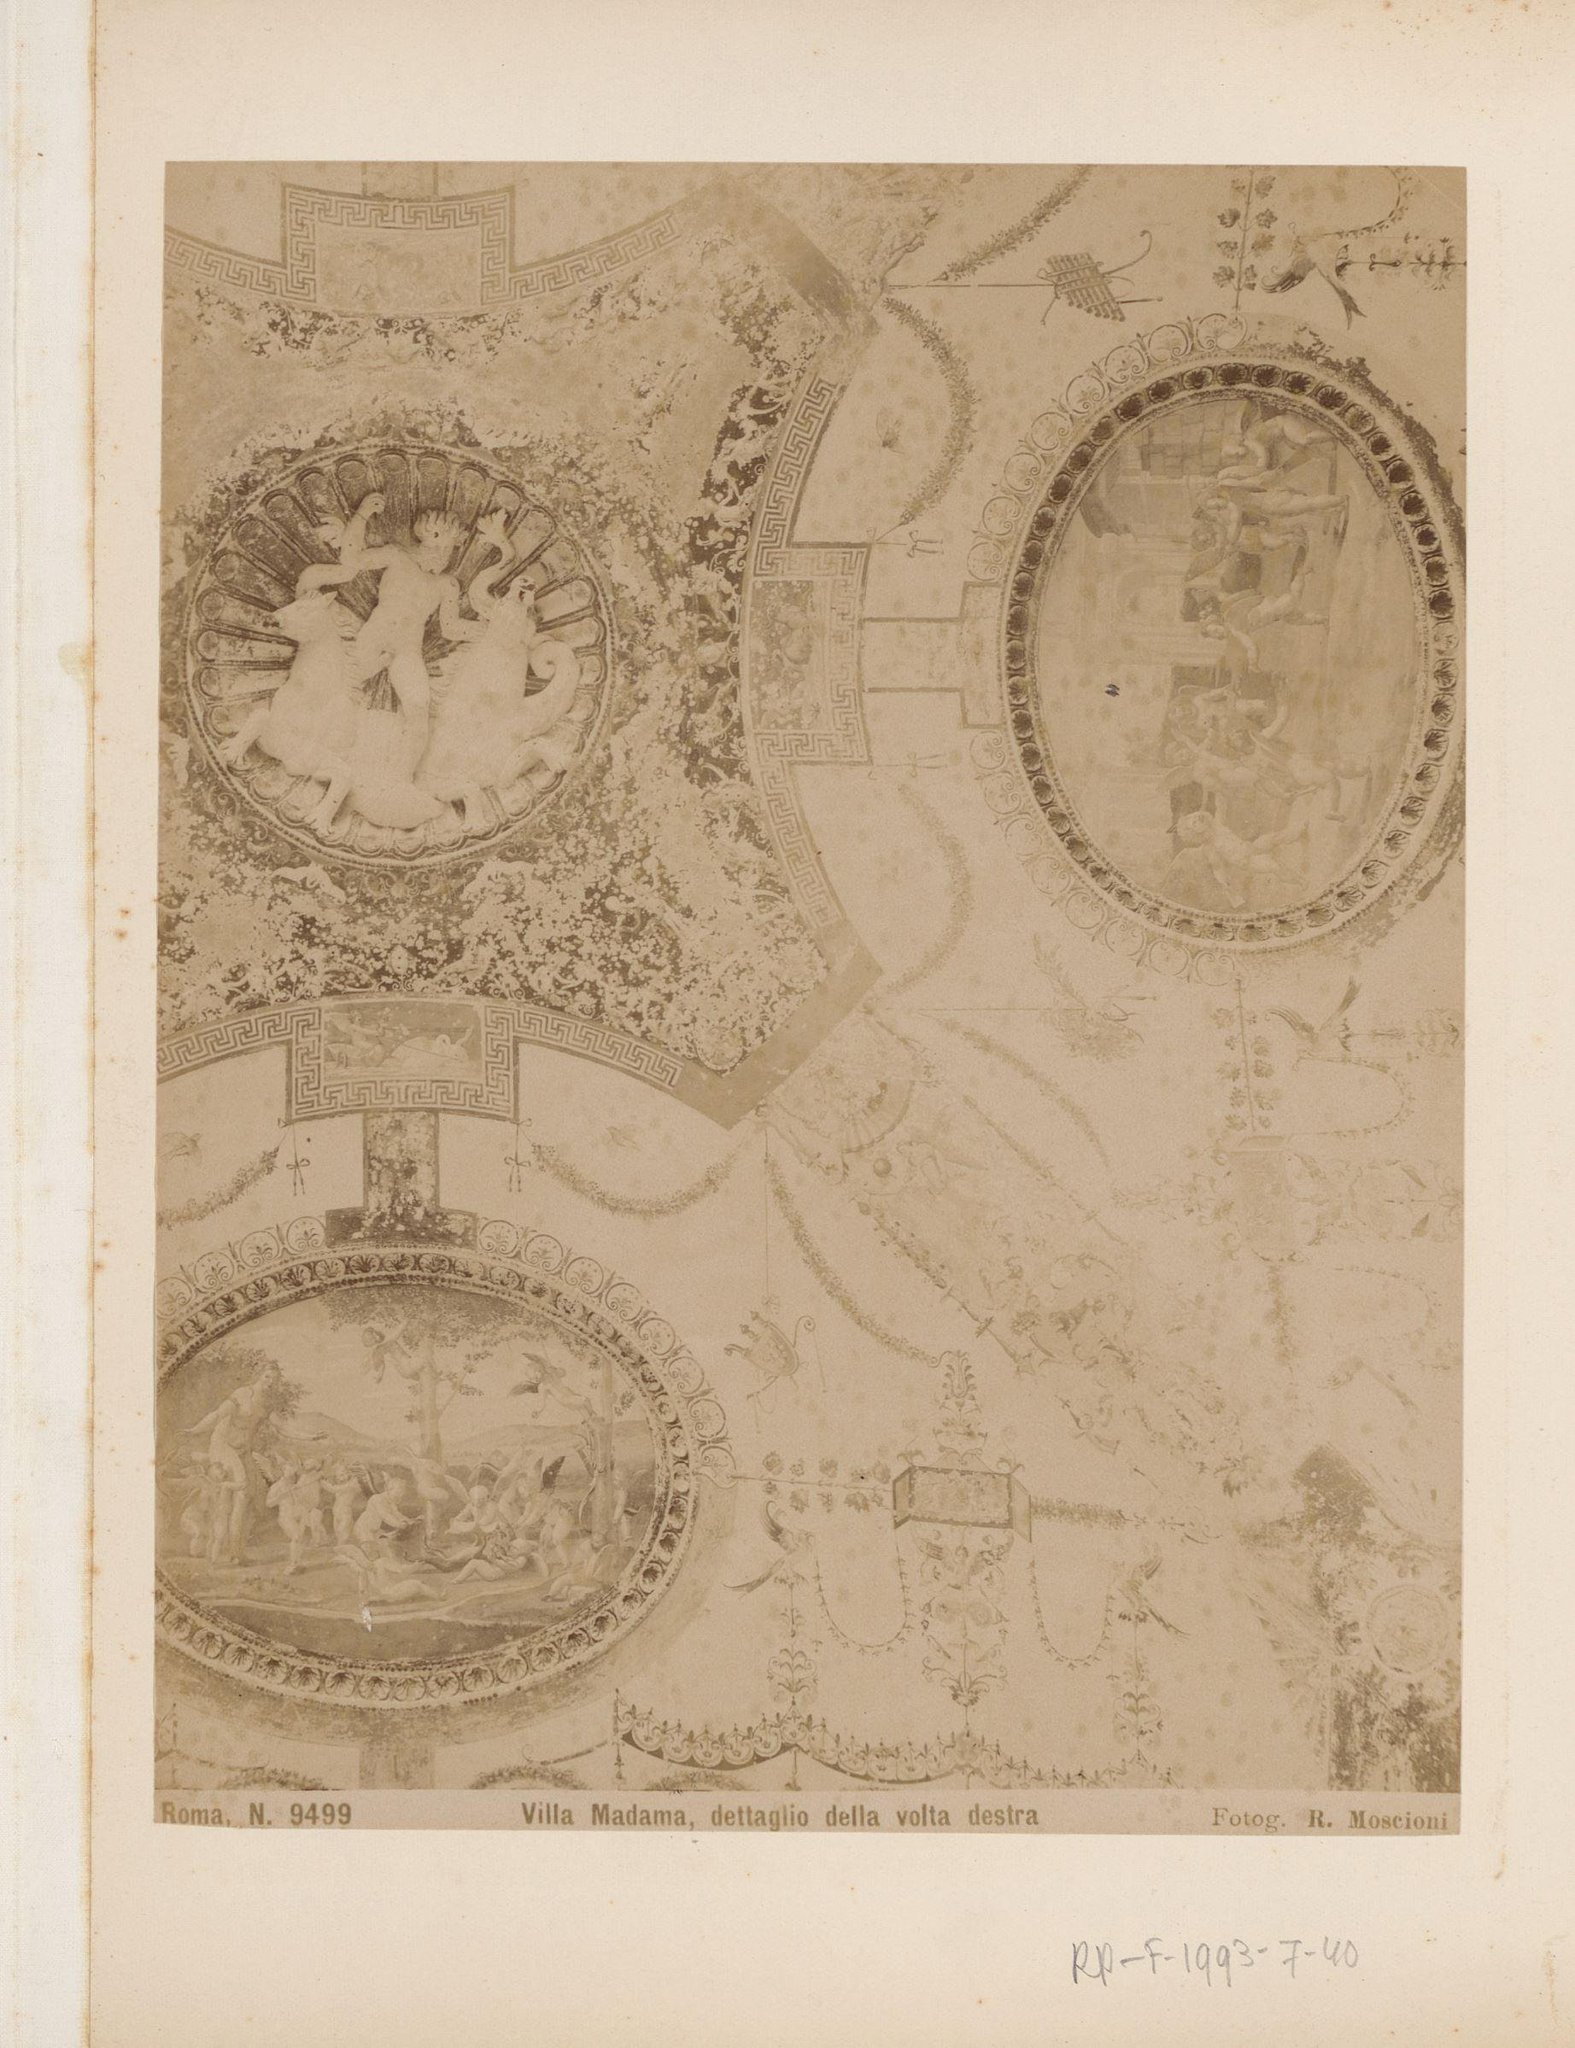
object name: photograph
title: Roma, N. 9499 Villa Madama, dettaglio della volta destra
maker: romualdo moscioni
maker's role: fotograaf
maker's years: 1849-1925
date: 1868-1900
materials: paper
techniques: albumen print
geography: villa madama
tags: villa - aa - civic architecture: inside, vault ~ architecture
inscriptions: inscription: ‘Roma, N. 9499 Villa Madama, dettaglio della volta destra Fotog. R. Moscioni’